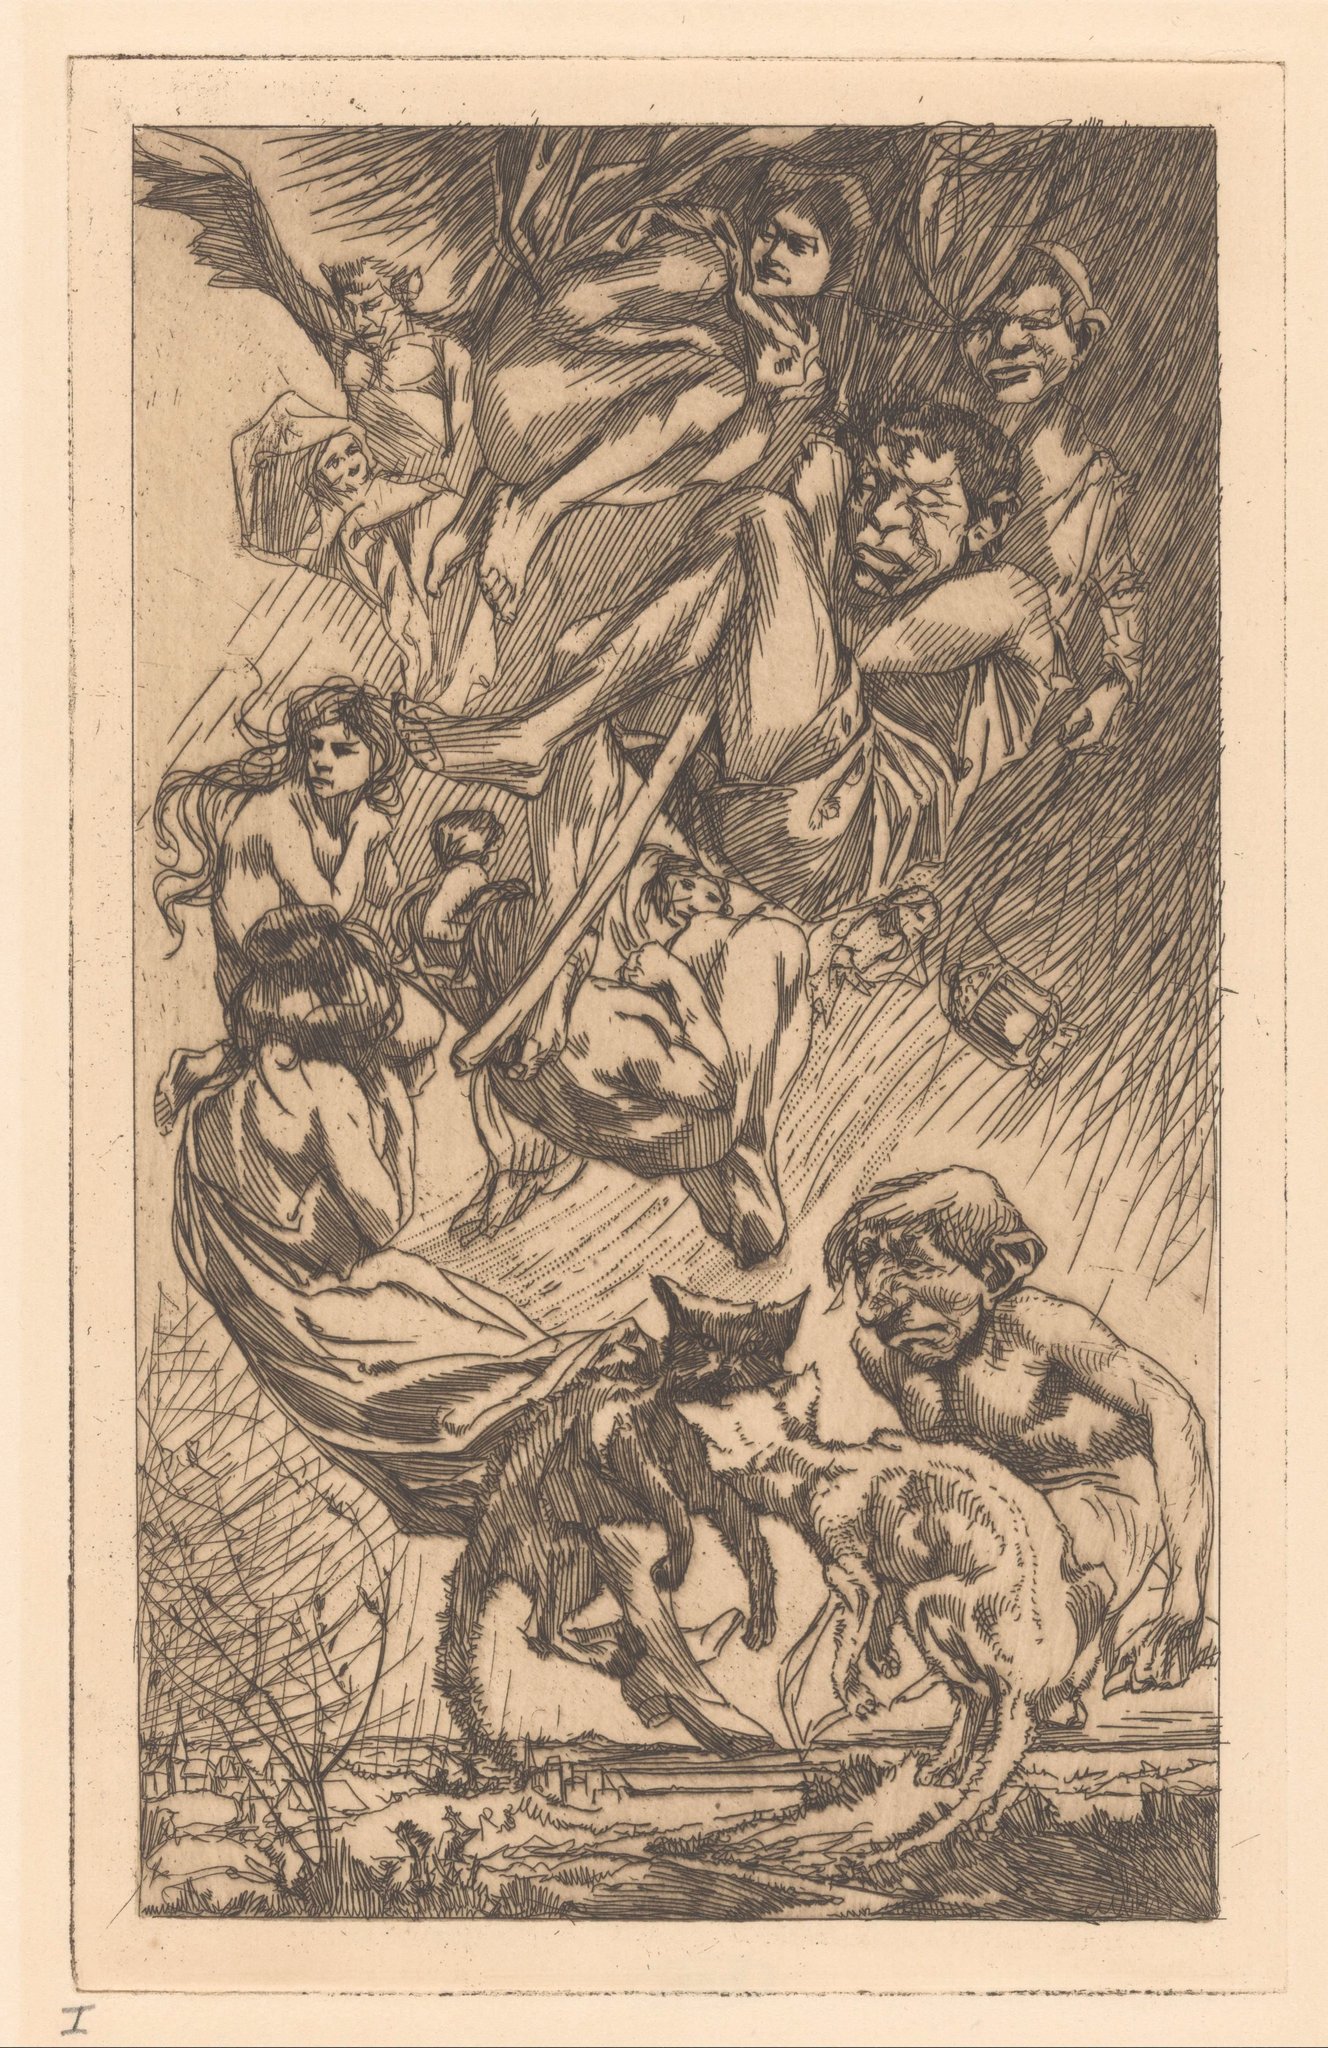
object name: print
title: Zwevende mensen, fantasiewezens en katten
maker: johannes josephus aarts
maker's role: draughtsman, print maker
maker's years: 1871-1934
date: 1881-1934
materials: paper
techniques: etching, intaglio, roulette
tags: movement in the air, cat, surrealia, surrealistic representations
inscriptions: collector's mark: Lugt 2228, collector's mark: Lugt 2166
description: Onder hen een vlak landschap met links bebouwing en in het midden een rivier.